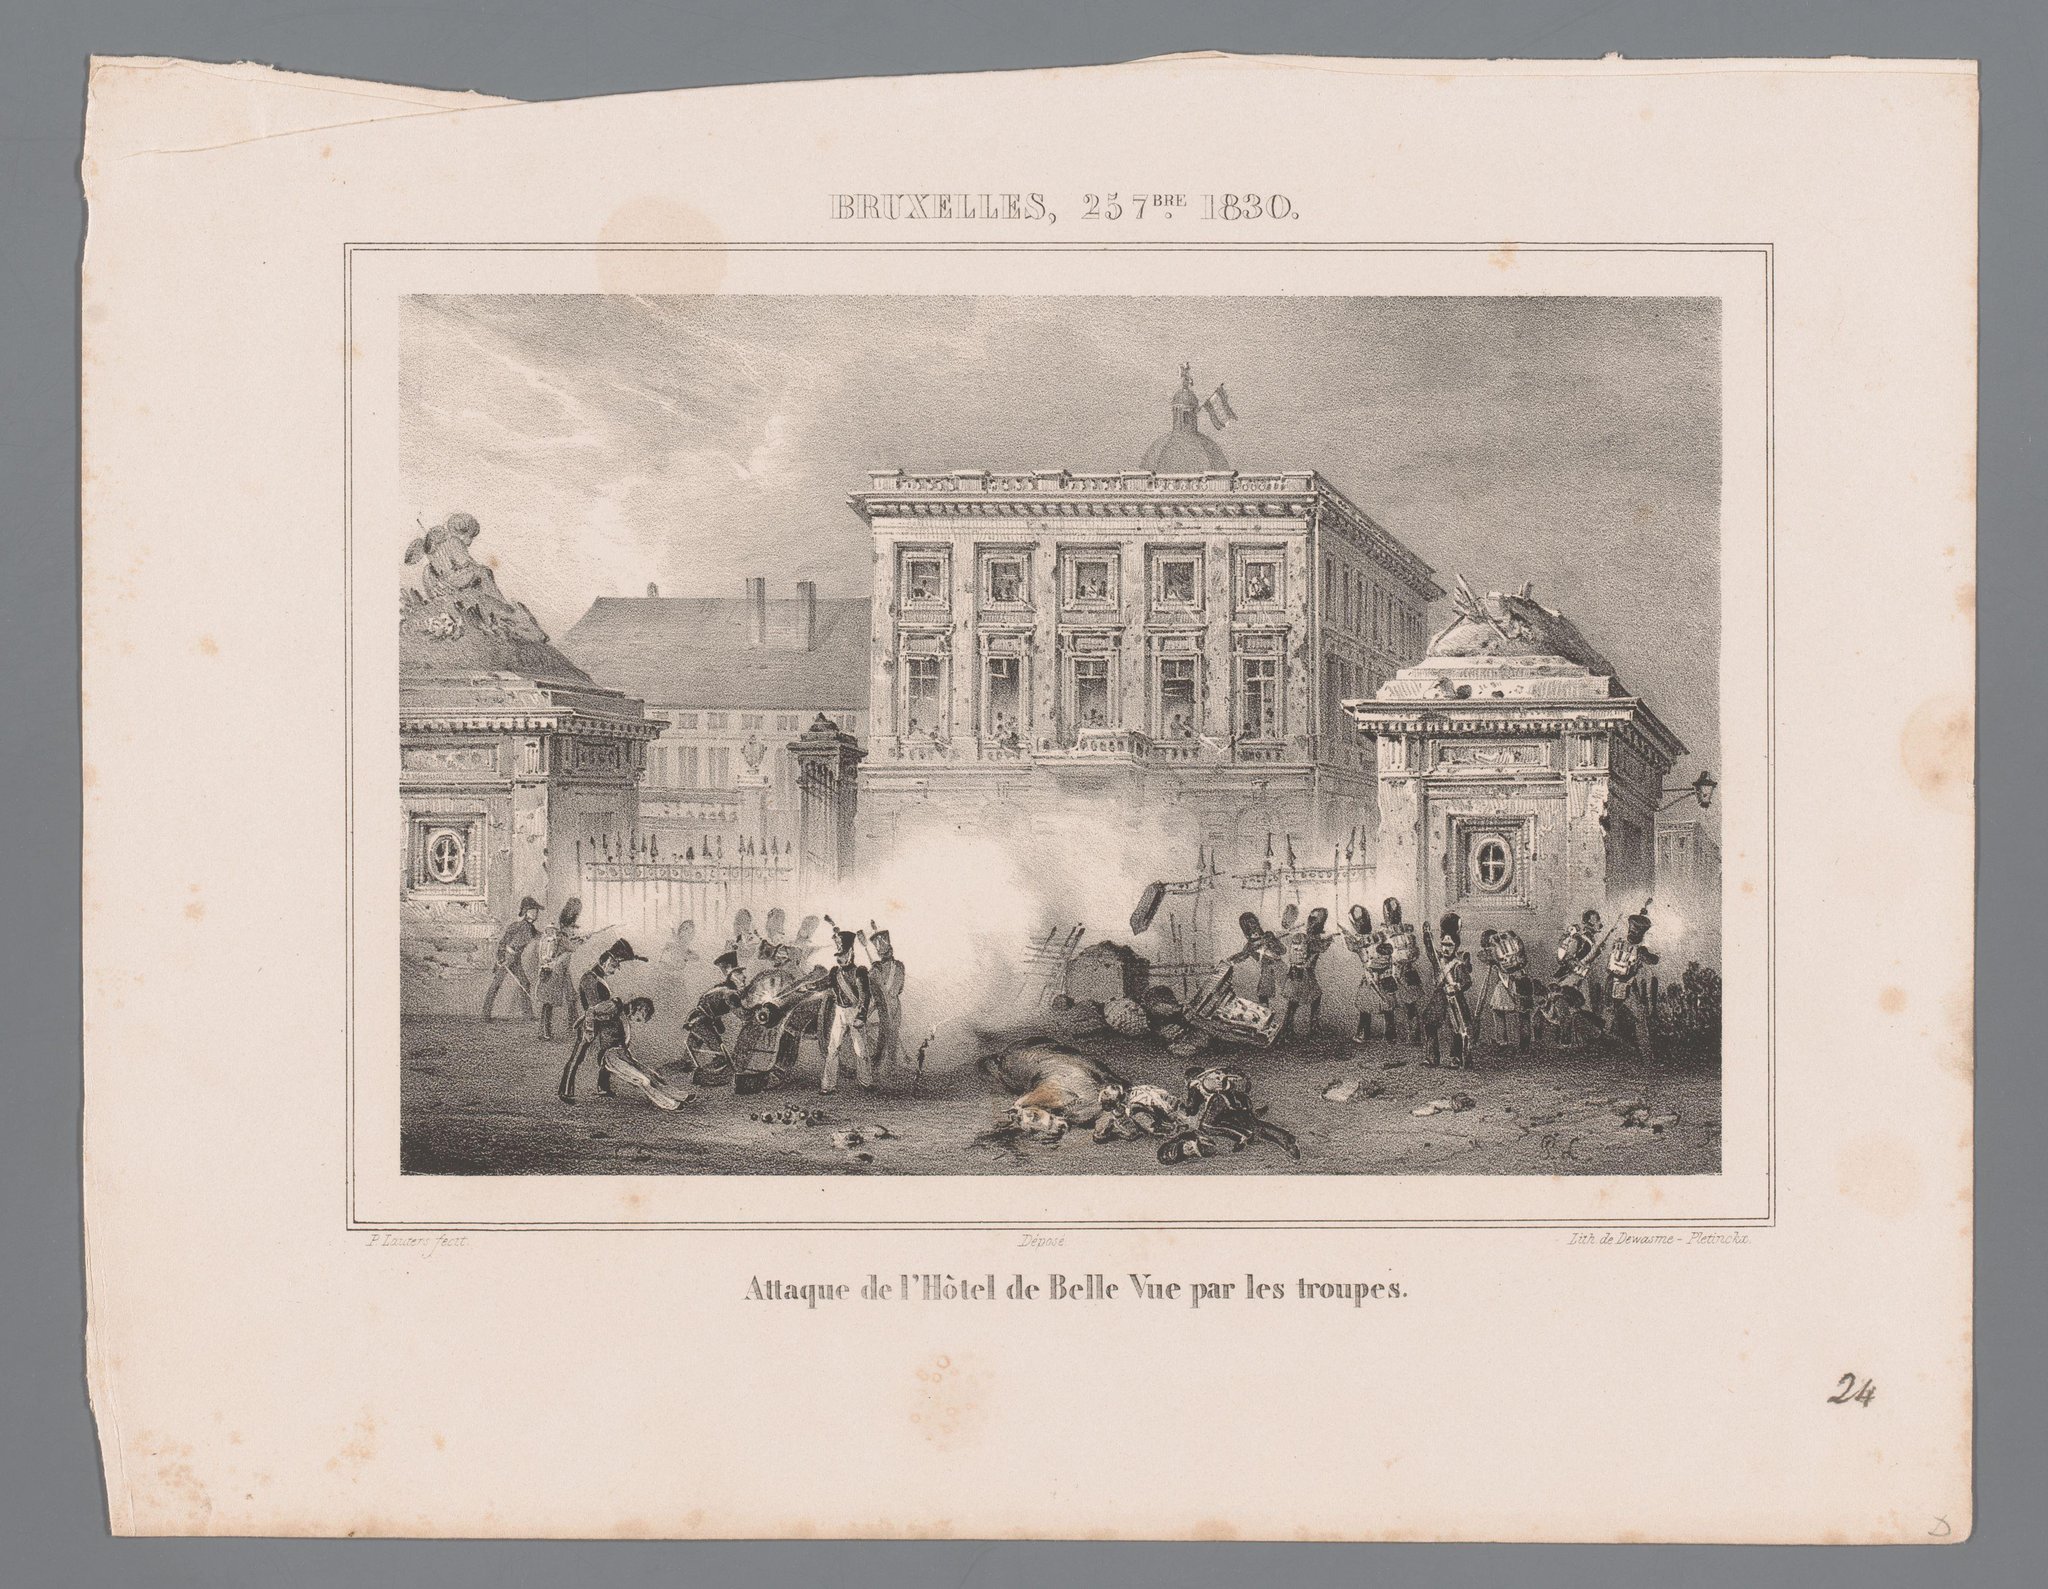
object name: print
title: Gebeurtenissen in Brussel, Antwerpen (...)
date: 1830-1831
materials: paper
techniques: lithograph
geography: brussels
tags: barricades ~ riot, battle, brussels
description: Prent maakt deel uit van een serie met prenten over de gebeurtenissen tijdens de Belgische Revolutie in Brussel, Antwerpen en andere steden in de periode 25 augustus 1830 tot 27 maart 1831.